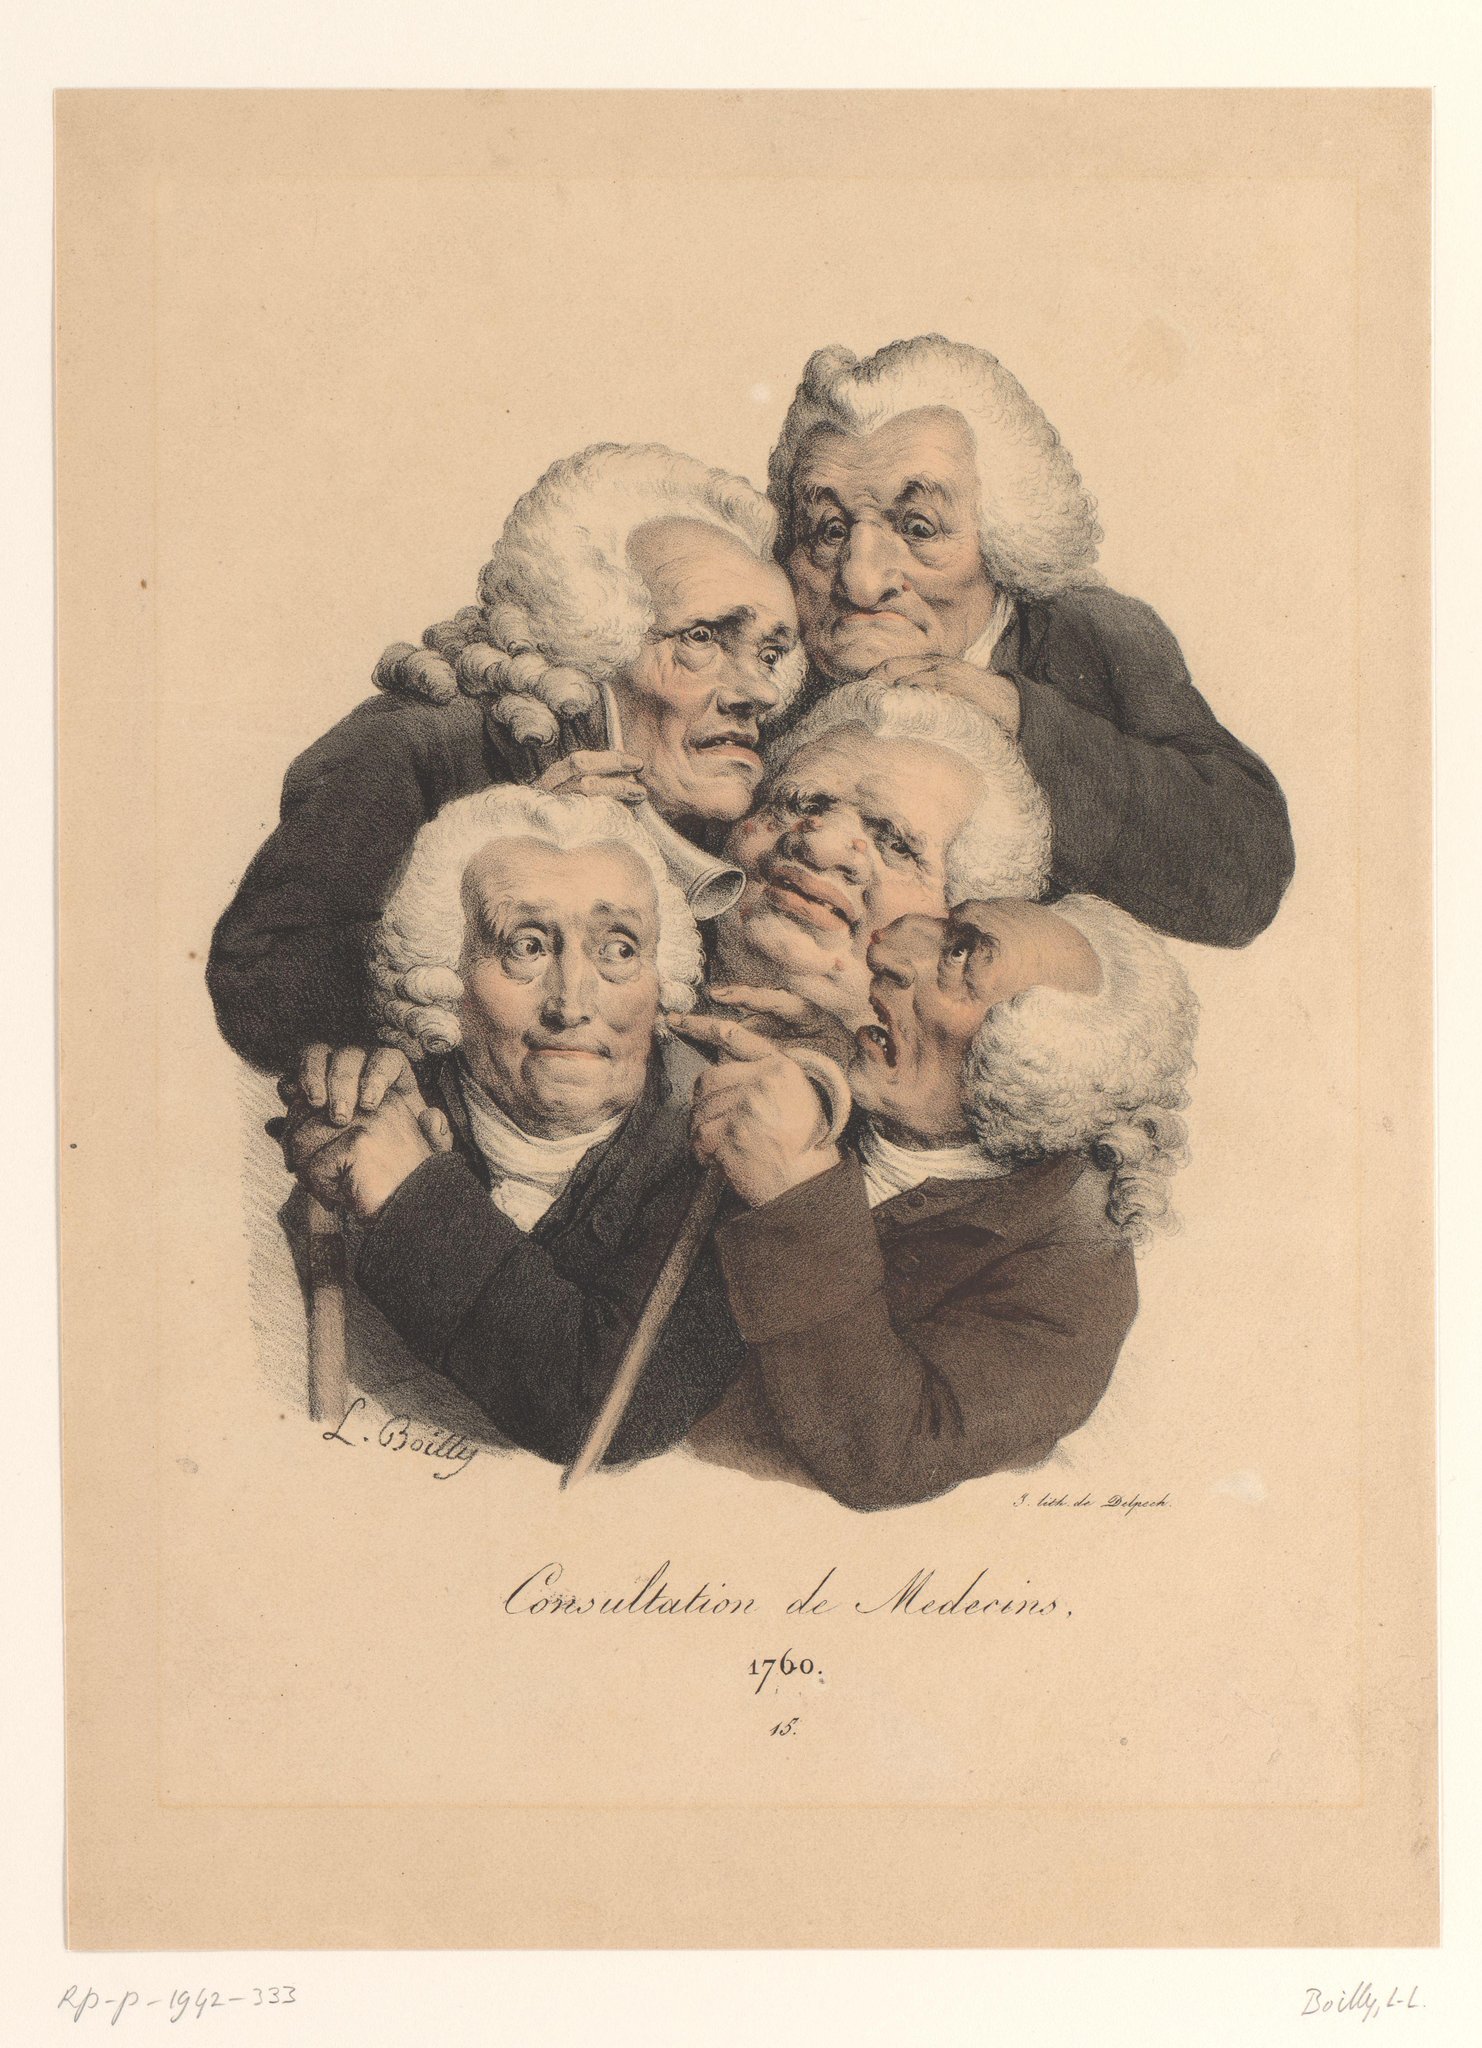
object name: cartoon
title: Gezichten met een grimas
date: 1823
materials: paper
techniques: hand coloring, lithograph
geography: paris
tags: caricatures (human types), physician, doctor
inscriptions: collector's mark: Lugt 2760, collector's mark: Lugt 2228a